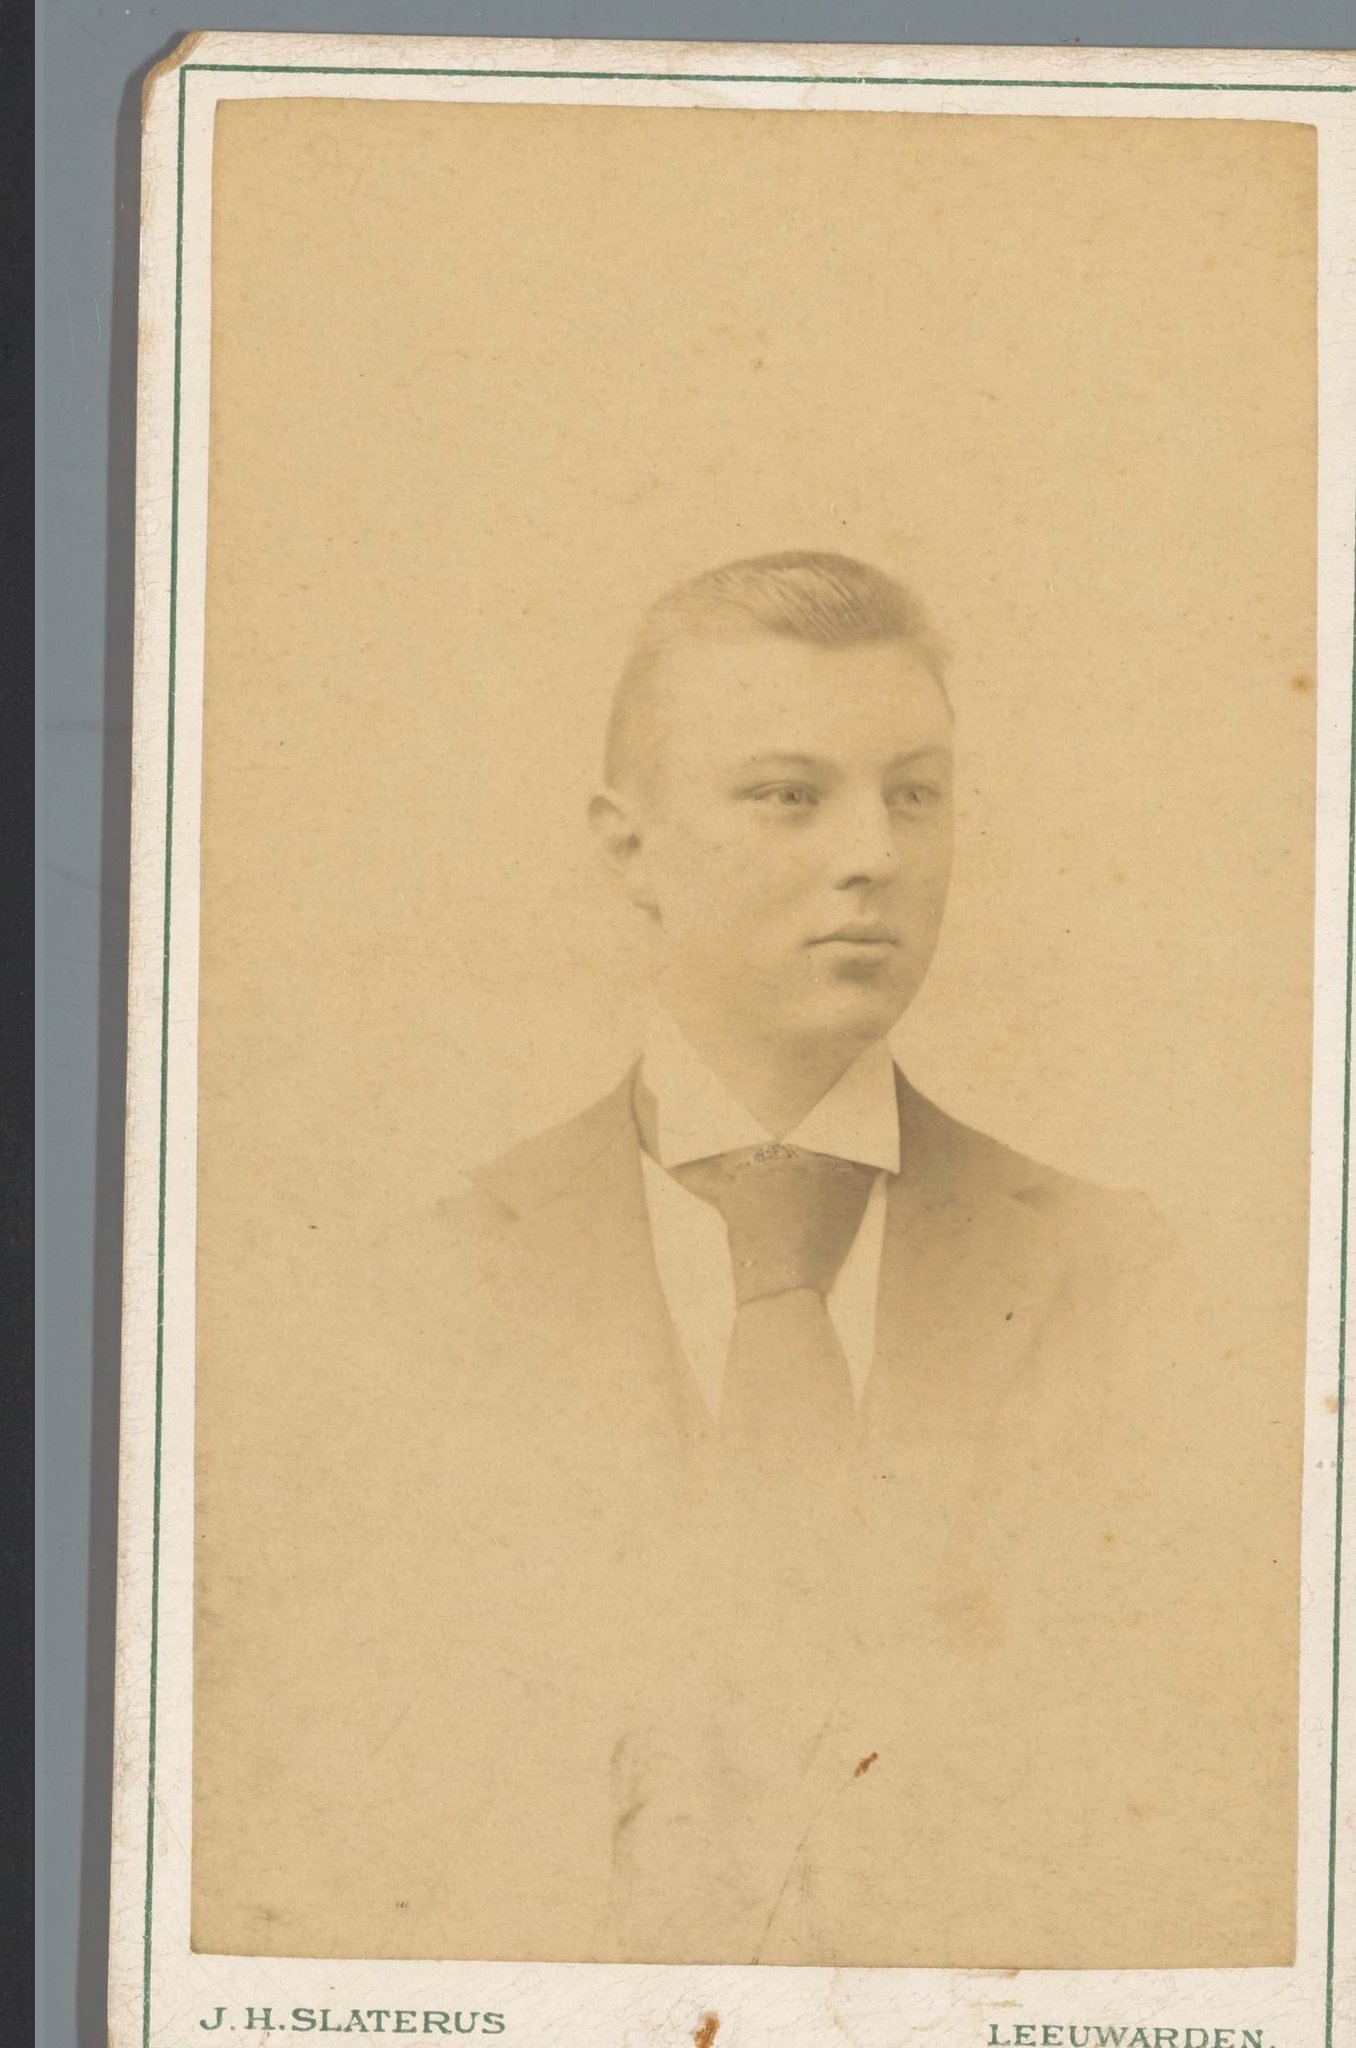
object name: carte de visite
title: Portret van een onbekende man, aangeduid als Th. Lucassen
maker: idanus hendrikus slaterus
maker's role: fotograaf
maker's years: 1846-1921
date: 1896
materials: cardboard, paper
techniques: albumen print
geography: leeuwarden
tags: adult man, historical persons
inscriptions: inscription: ‘Photographie Instantanée/ J. H. SLATERUS/ Langemarktstraat/ tegenover het Station bij de/ nieuwe Veearkt/ Let. W. No. 14/ LEEUWARDEN.’, inscription: ‘29 Jan 96/ Leeuwarden/ Th. Lucassen’